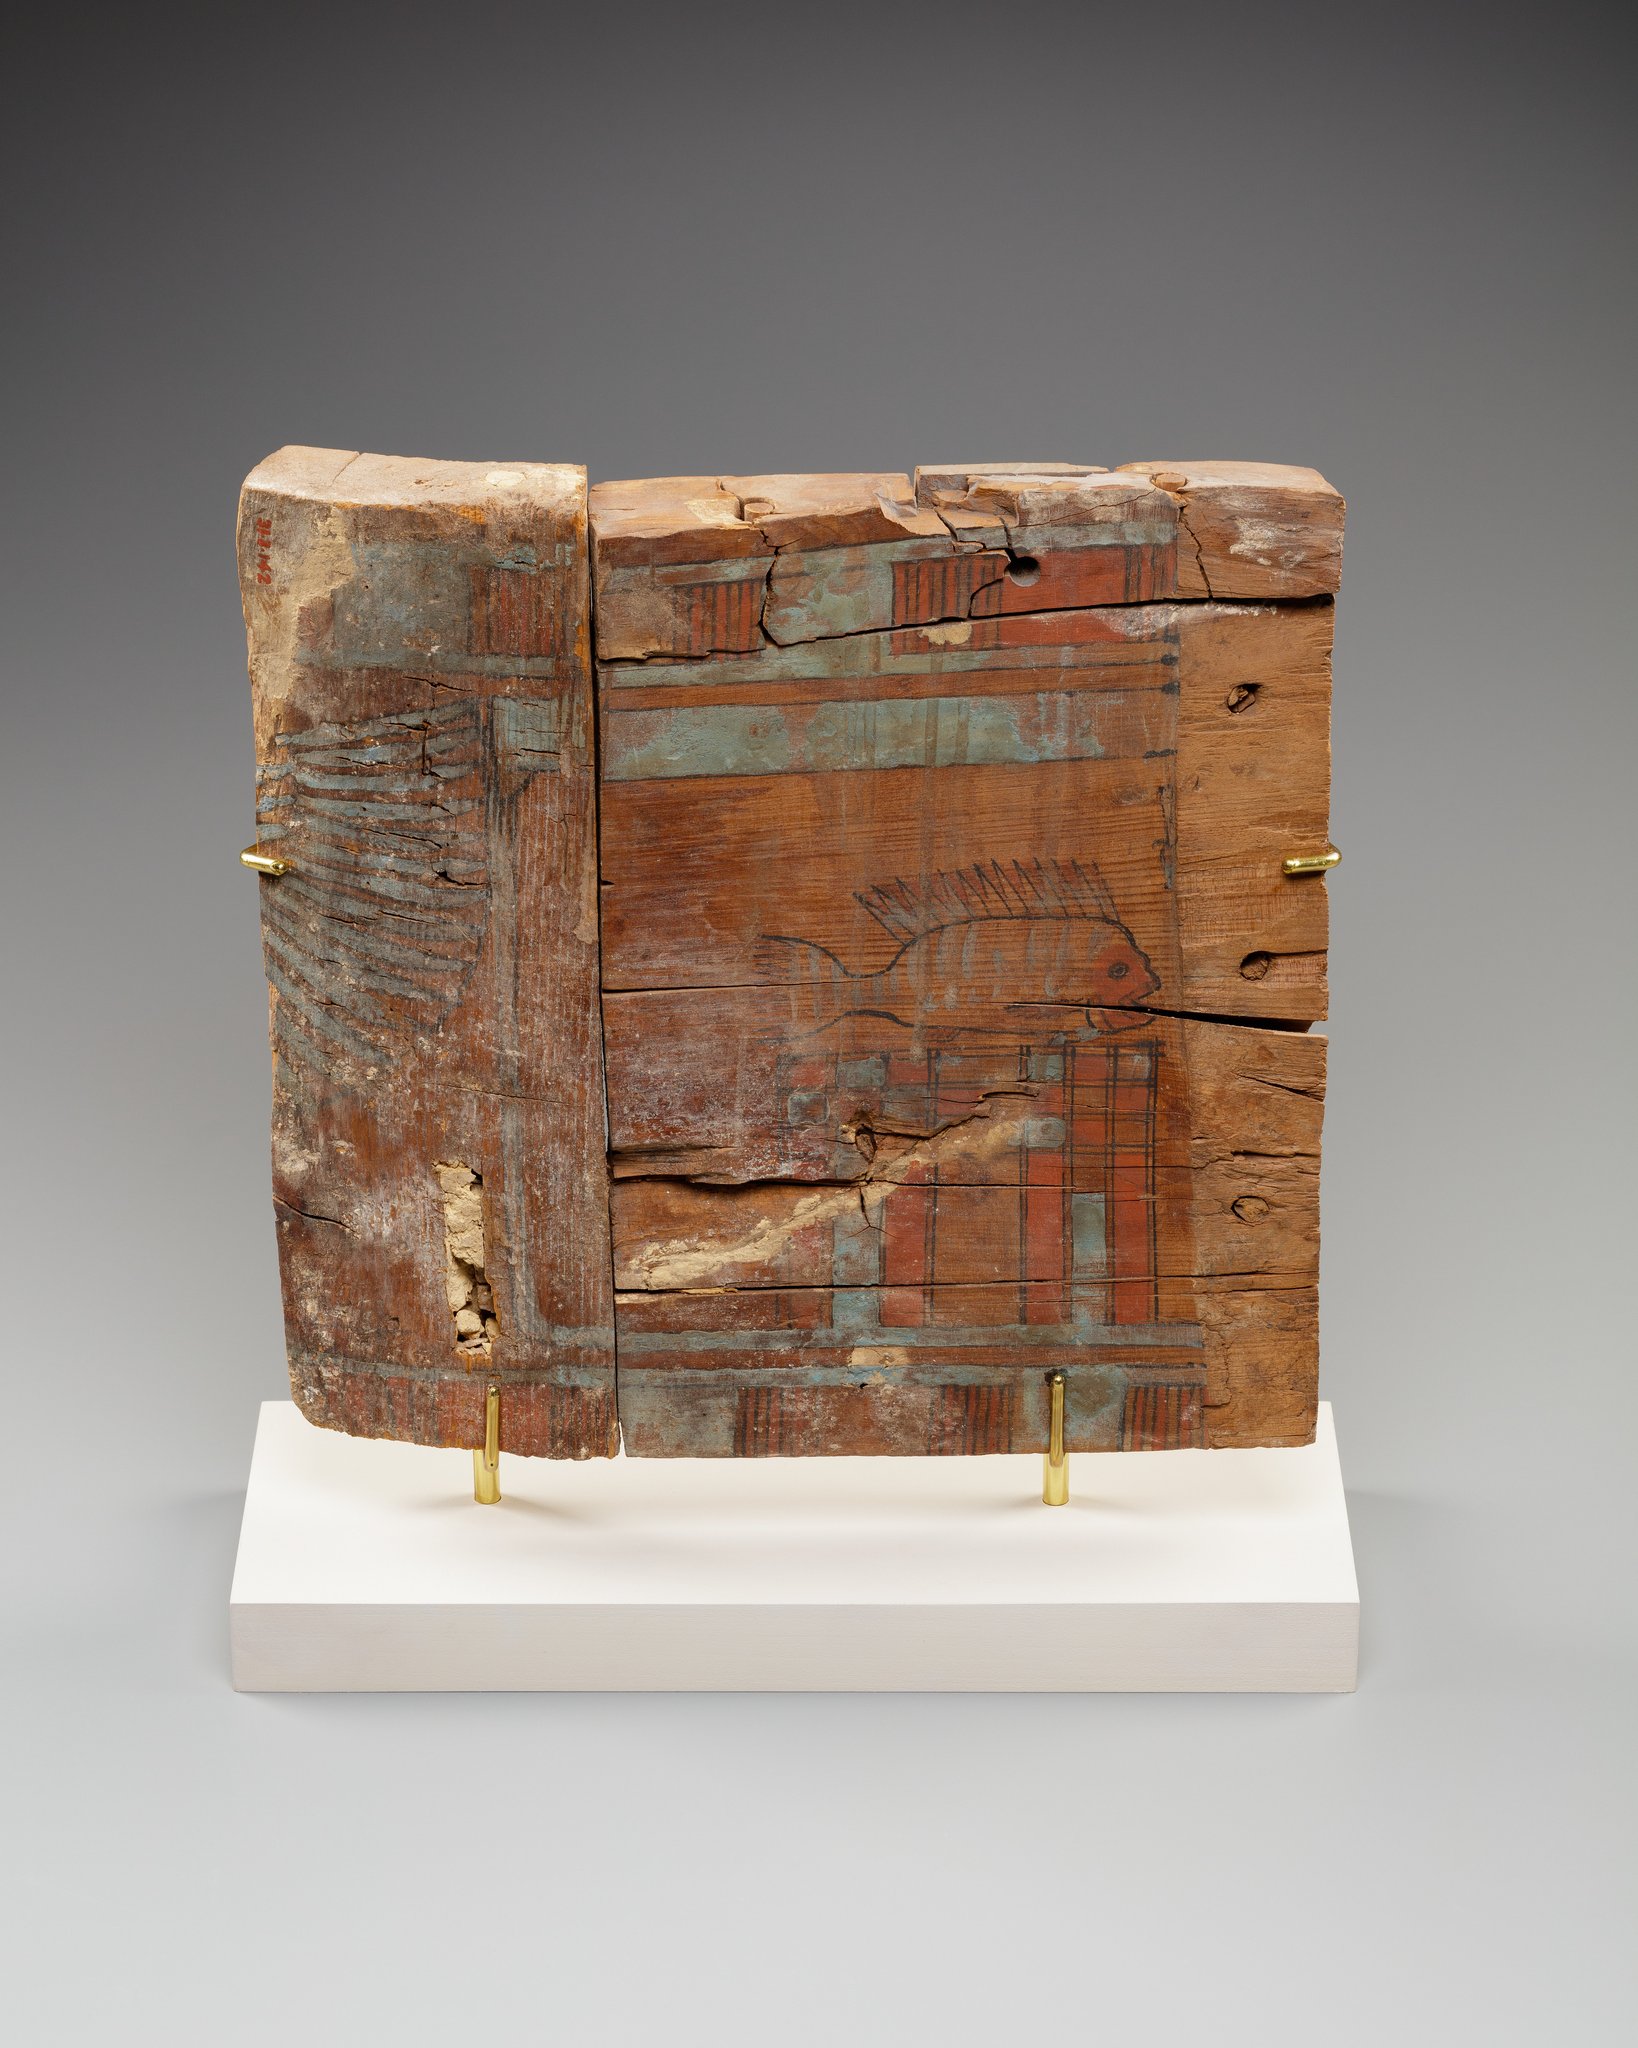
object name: coffin head, fish drawing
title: Part of the head of an inner coffin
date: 712-664 BCE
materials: ink, wood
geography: egypt